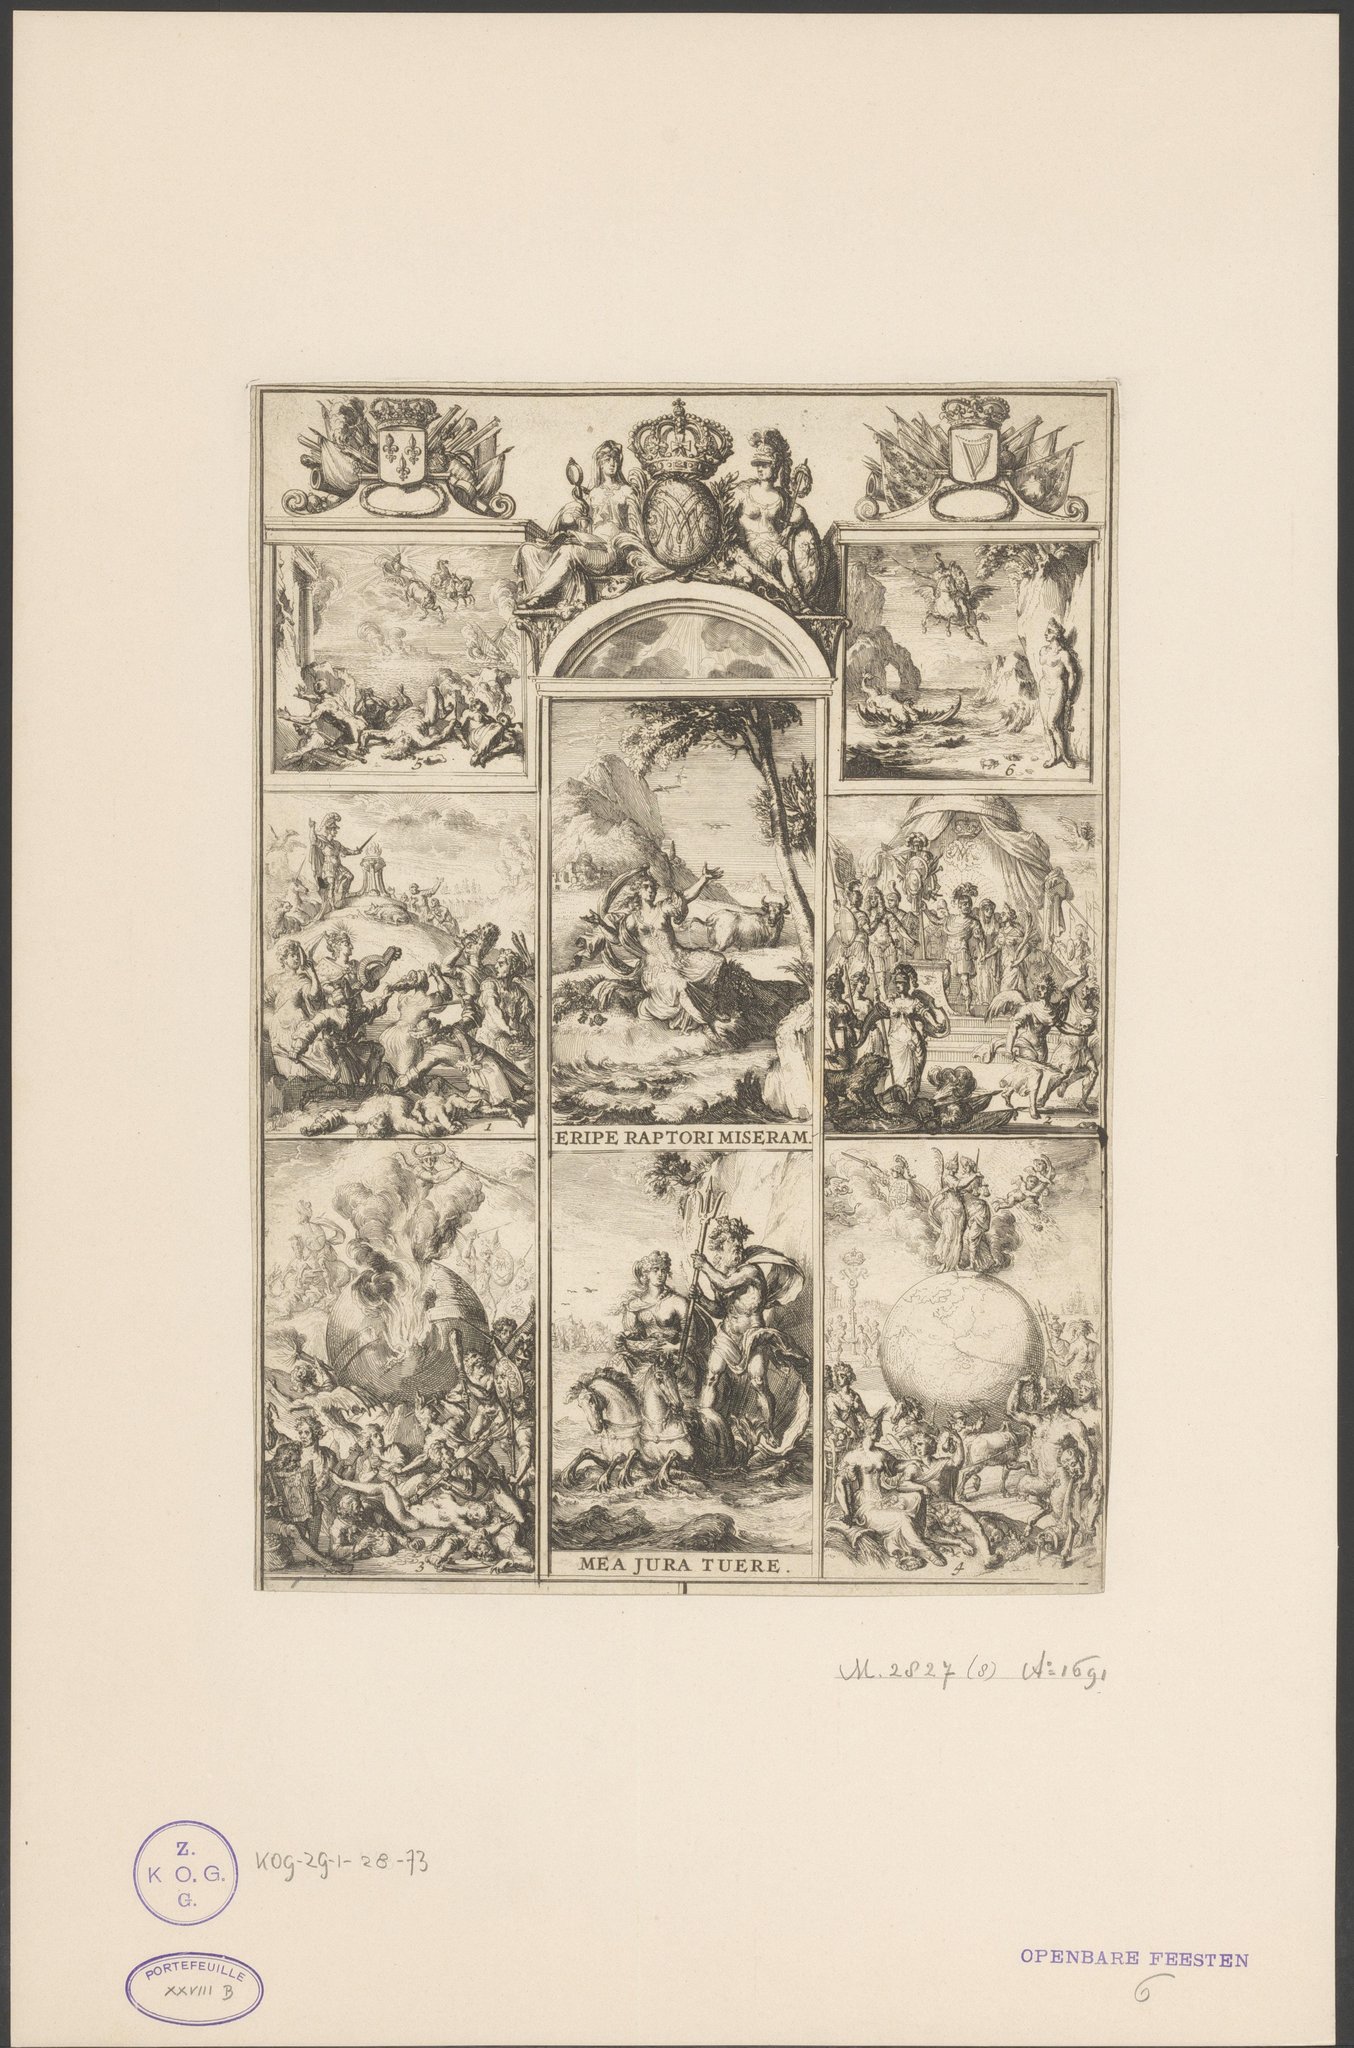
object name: print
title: Schilderijen op de triomfboog op de Plaats, 1691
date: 1691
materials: paper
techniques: etching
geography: rotterdam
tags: the hague, william iii (prince of orange and king of england, scotland, and ireland), (story of) neptune (poseidon), perseus kills the sea monster (or turns it into stone by showing it the gorgon's head) to release andromeda; sometimes her parents cepheus and cassiopea watch the scene, triumphal arch, triumphal entry and public reception, pageant, 'entrée solennelle', 'joyeuse entrée', justitia (justice) as roman personification, pax as roman personification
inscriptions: collector's mark: Lugt 1641, stamp, stamp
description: Schilderijen op de triomfboog op de Plaats, opgericht door het stadsbestuur voor de intocht van stadhouder-koning Willem III te Den Haag, 5 februari 1691. Acht allegorische en mythologische voorstellingen, de buitenste voorstellingen zijn genummerd 1 t/m 6. Onderwerpsrubrieken binnen de Atlas Zeden en Gewoonten: Zeden en Gewoonten in Engeren Zin. Volksleven. Openbare feesten. Vorstelijke intochten, (Illuminaties, vuurwerken en dergelijke, openbare feesten).